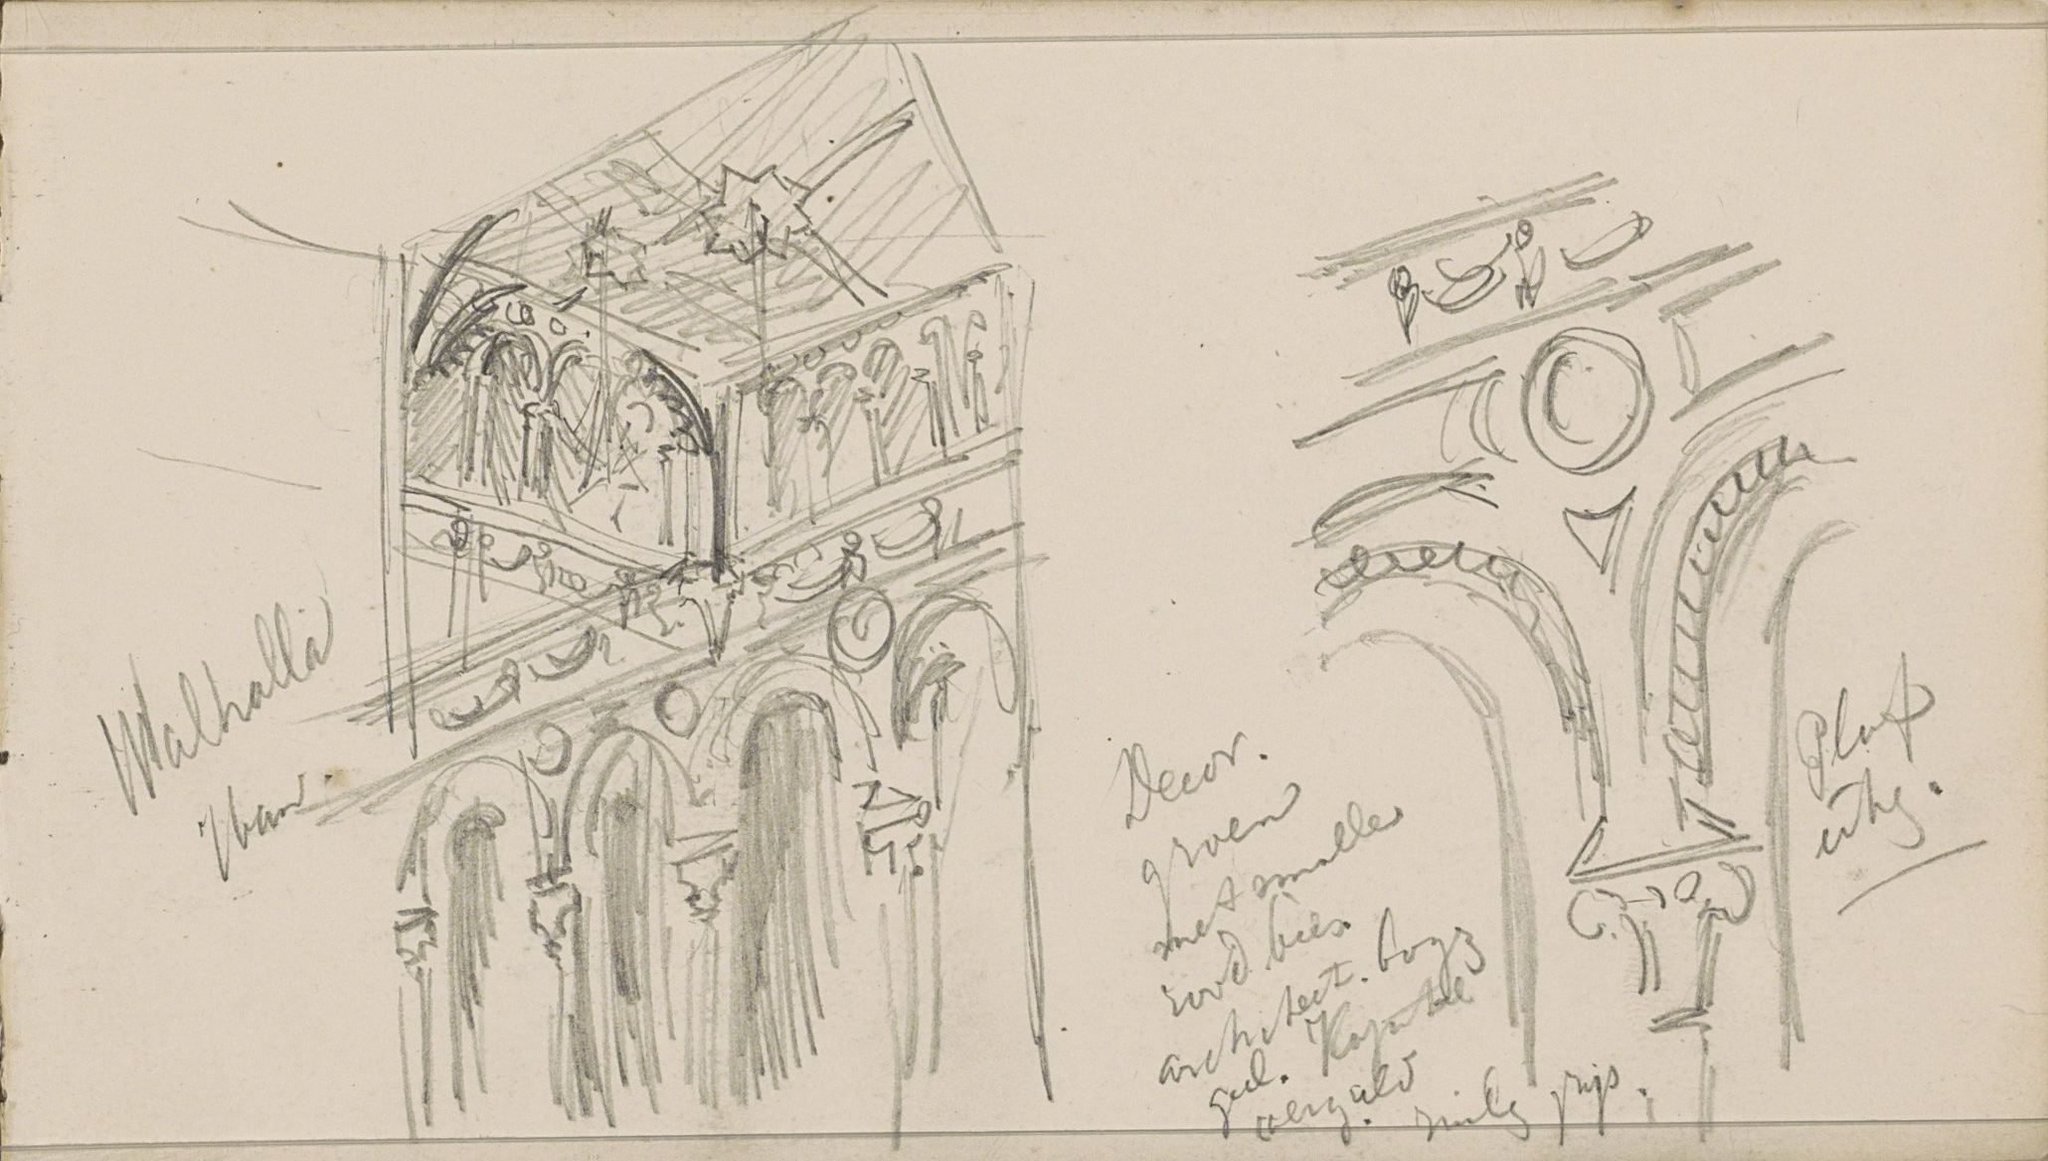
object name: sketchbook leaf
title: Interieur met een zuilengalerij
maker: isaac gosschalk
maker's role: draughtsman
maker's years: 1838-1907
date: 1866-1868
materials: paper, pencil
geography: hannover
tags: interior ~ representation of a building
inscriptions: annotation: ‘Walhalla/ Han/ Decor./ groen/ met smalle/ rood bies/ architect [...]oyz/ geel. k[...]/ verguld/ [...] grjs/ Plat/ eik’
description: Blad 6 recto uit een schetsboek met 67 bladen.